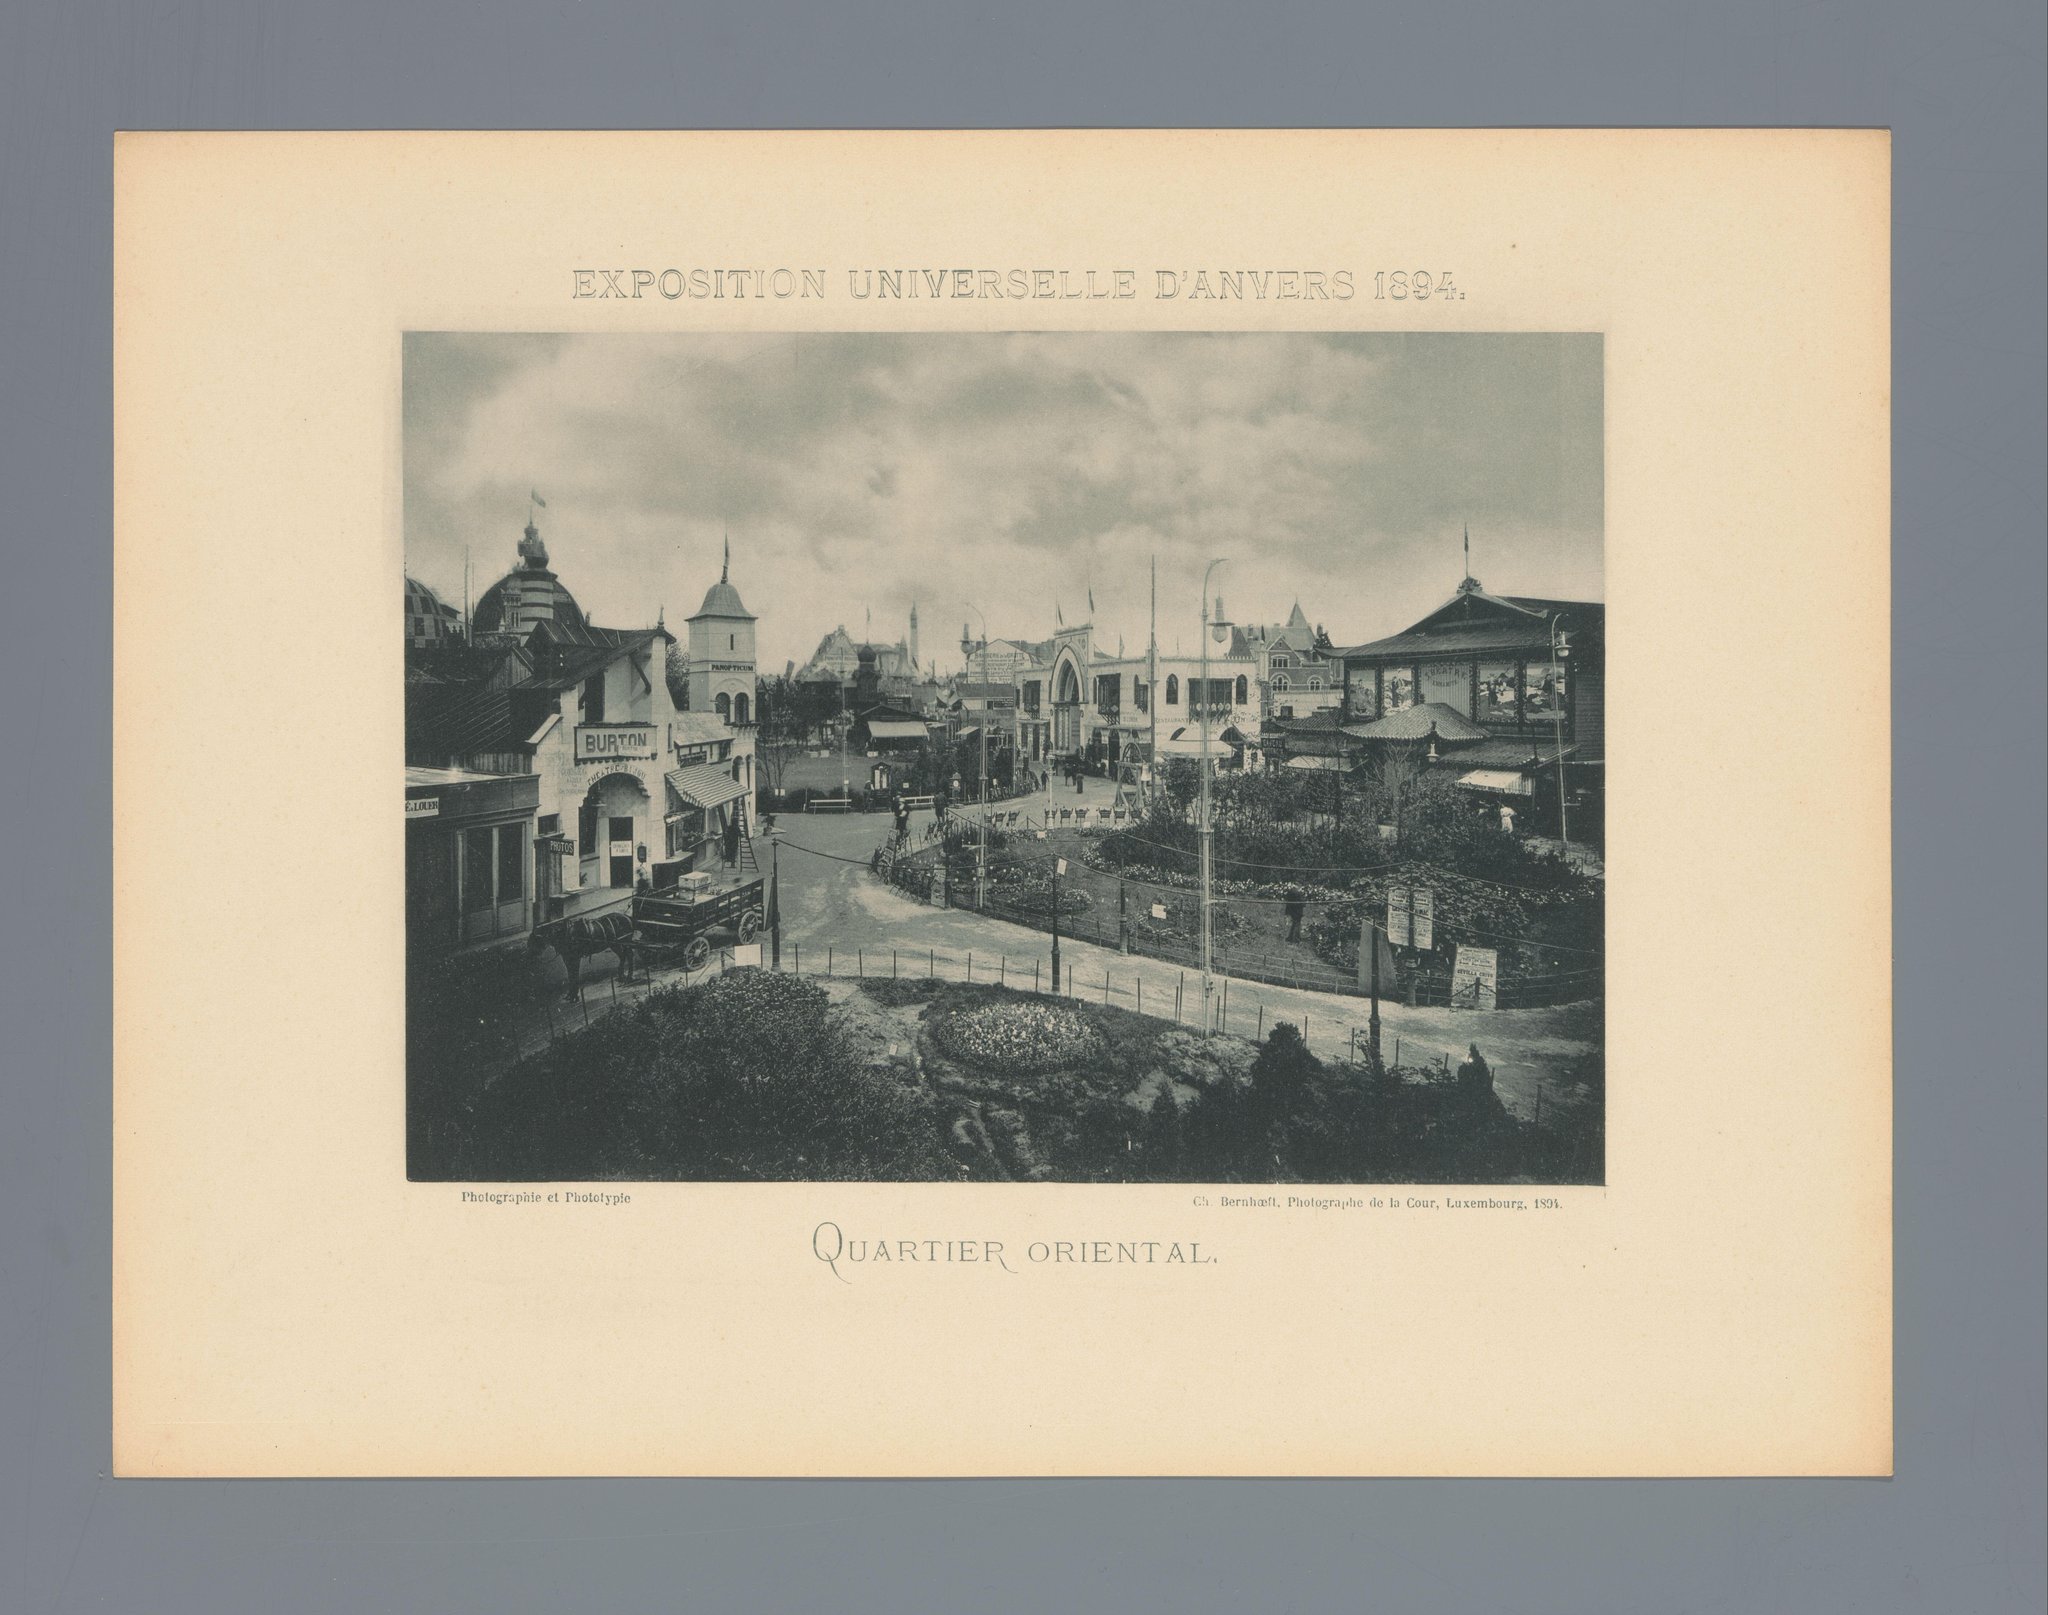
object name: photomechanical print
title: Gezicht op oriëntaalse paviljoens tijdens de Wereldtentoonstelling van 1894 te Antwerpen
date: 1894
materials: paper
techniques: photograph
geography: antwerp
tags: city-view in general; 'veduta', world fair, world exhibition, antwerp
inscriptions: inscription: ‘Exposition Universelle D'Anvers 1894.’